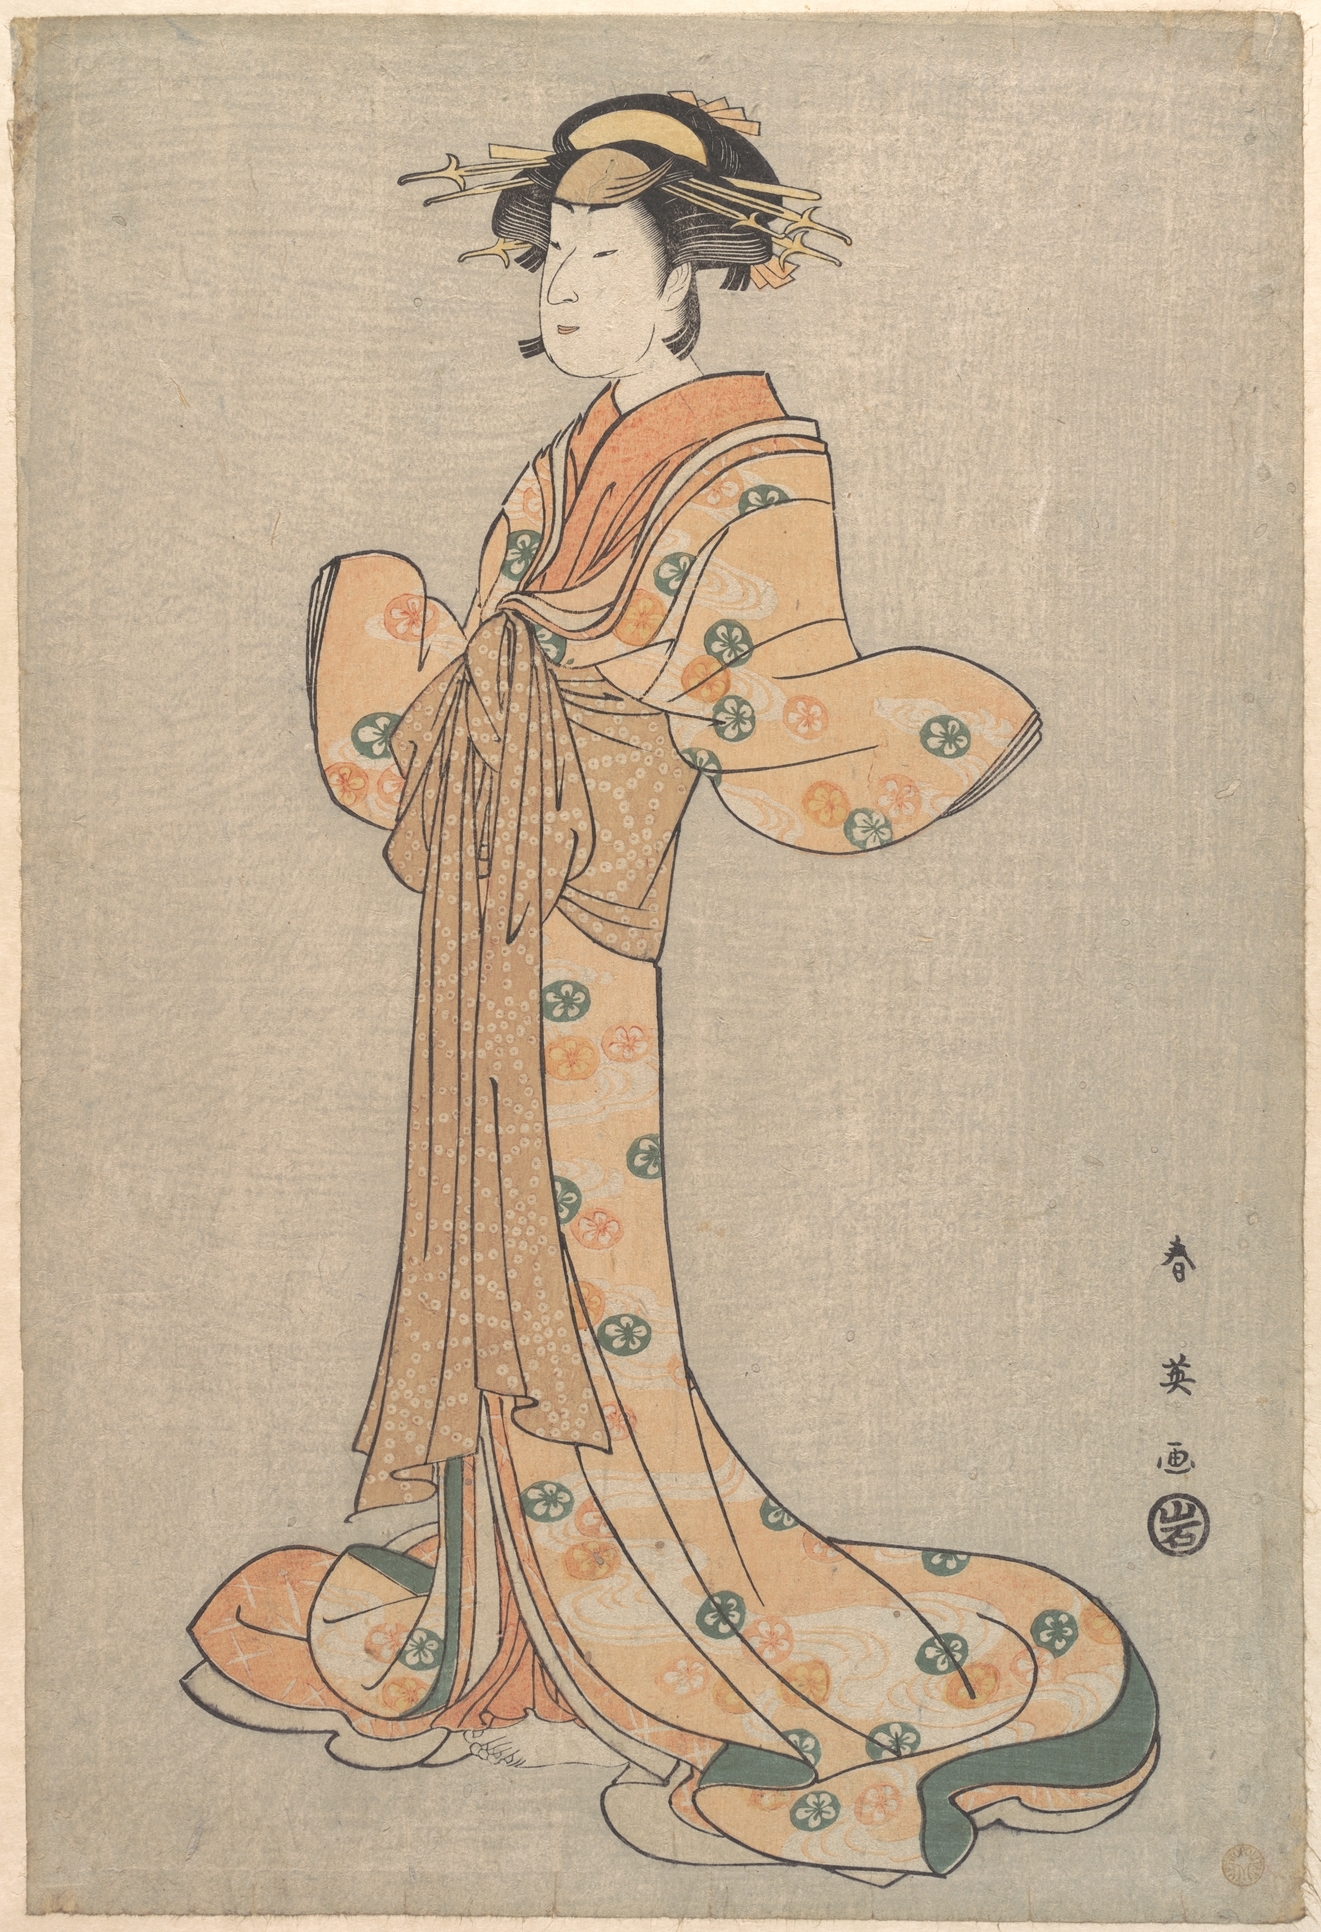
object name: woodblock print nishiki e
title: The Actor Nakamura Noshio II as the Courtesan Okaru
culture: japanese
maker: katsukawa shun'ei 勝川春英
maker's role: artist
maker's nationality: japanese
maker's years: 1762-1819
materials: ink, paper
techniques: nishiki e, woodblock print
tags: women,actors